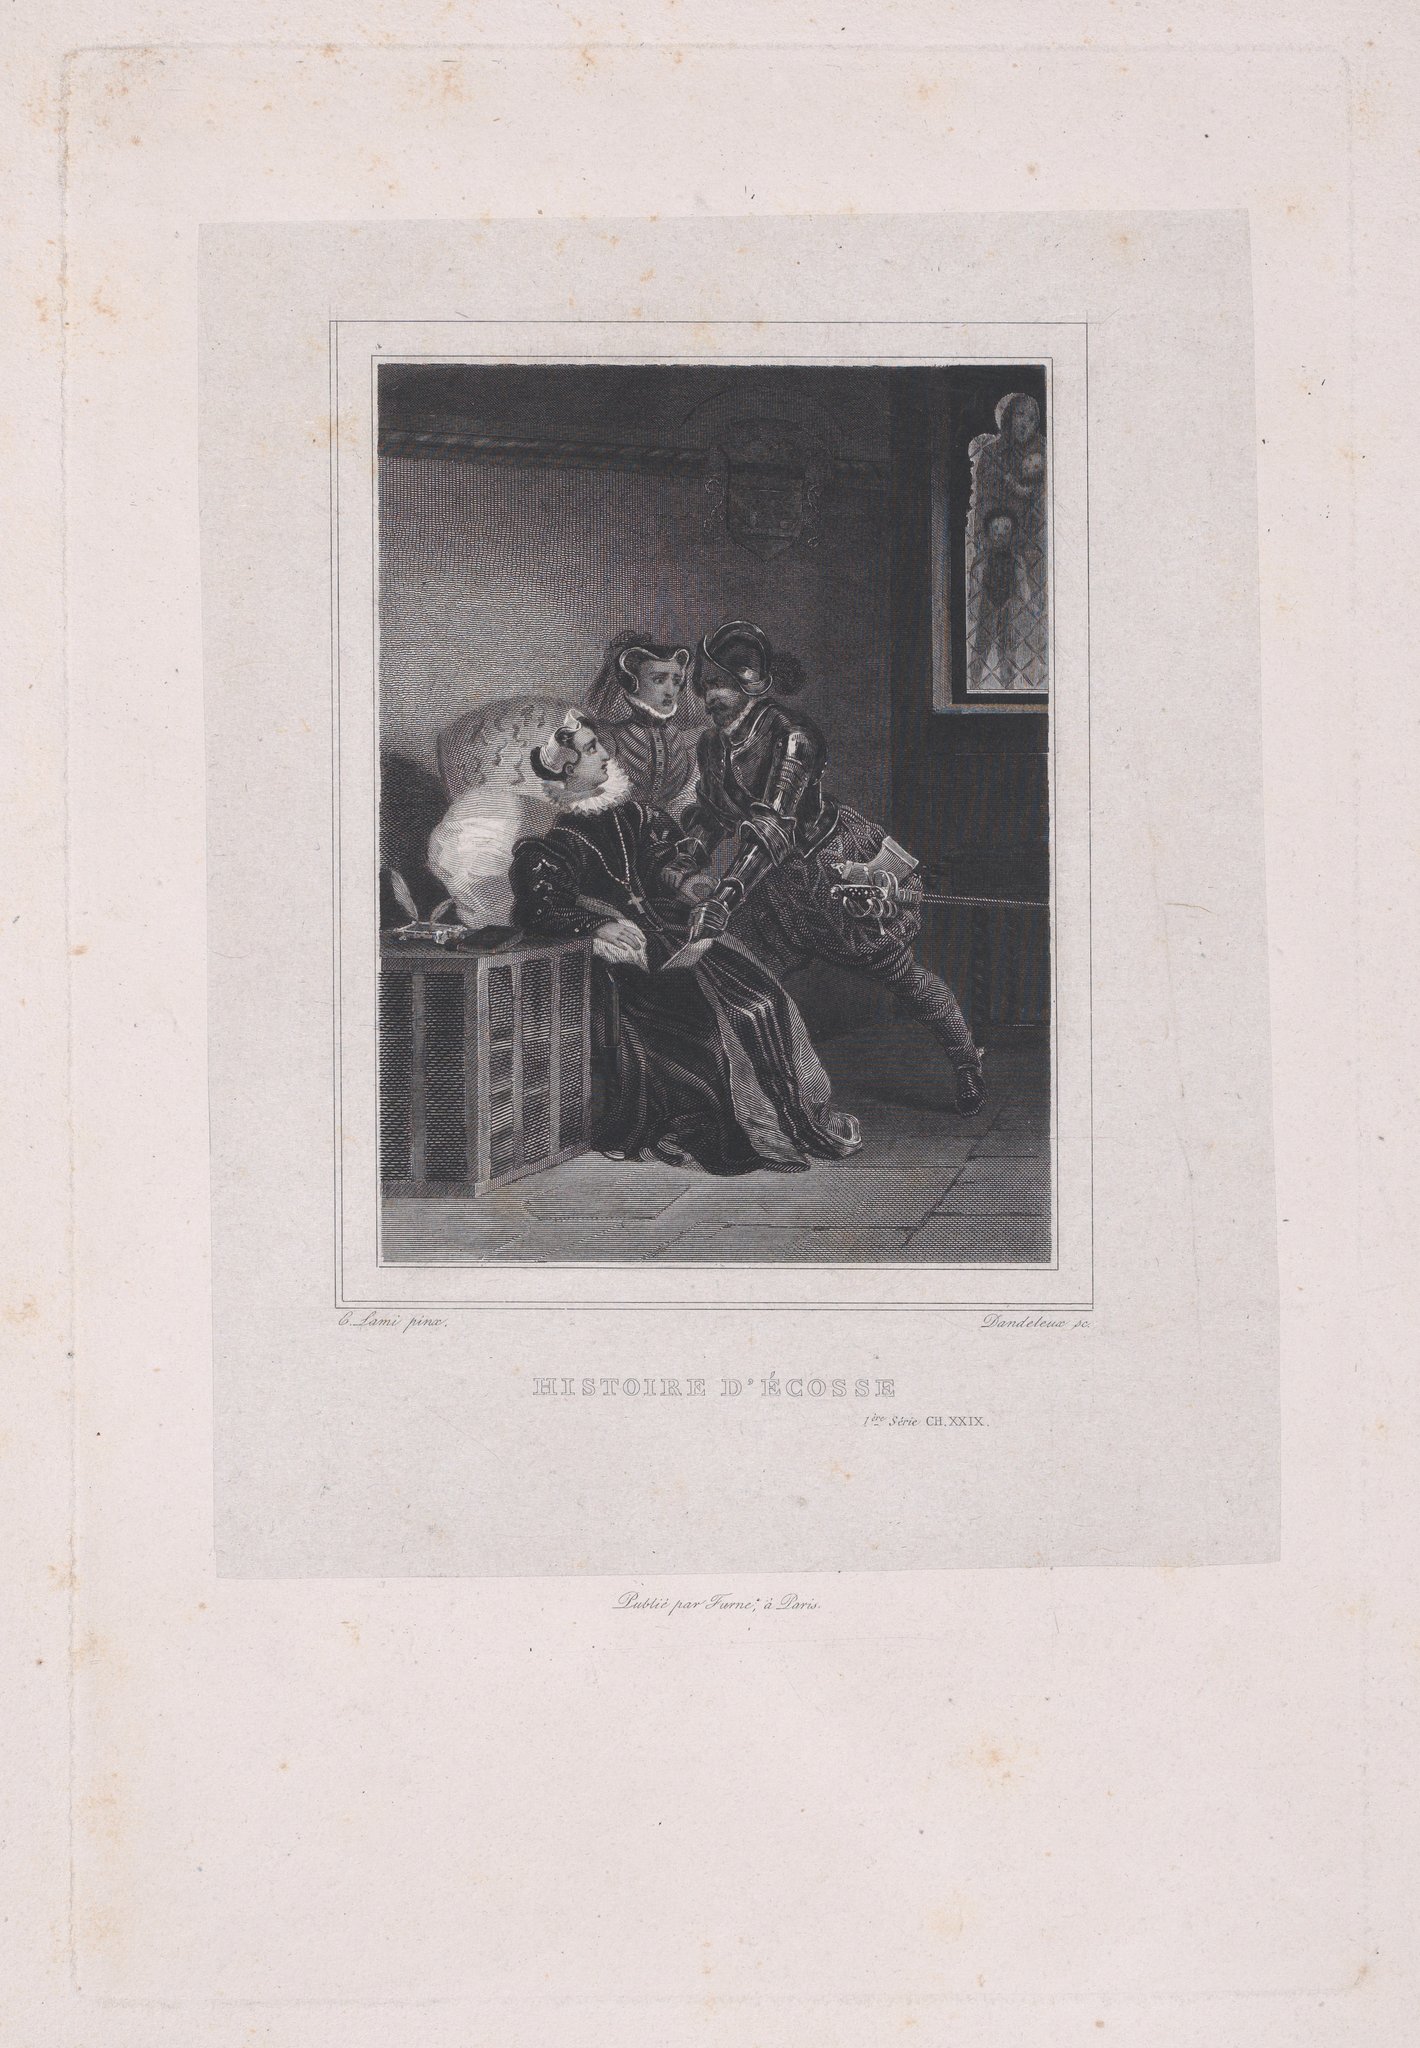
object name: print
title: Mary, Queen of Scots being urged by Sir Robert Melville to abdicate (from "Oeuvres de Walter Scott: Histoire d'Écosse," series one, volume 26, chapter 29)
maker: pierre-léonard dandeleux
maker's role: artist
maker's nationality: french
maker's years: 1783-1850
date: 1835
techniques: printmaking, etching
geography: france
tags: queens,men,women,mary queen of scots